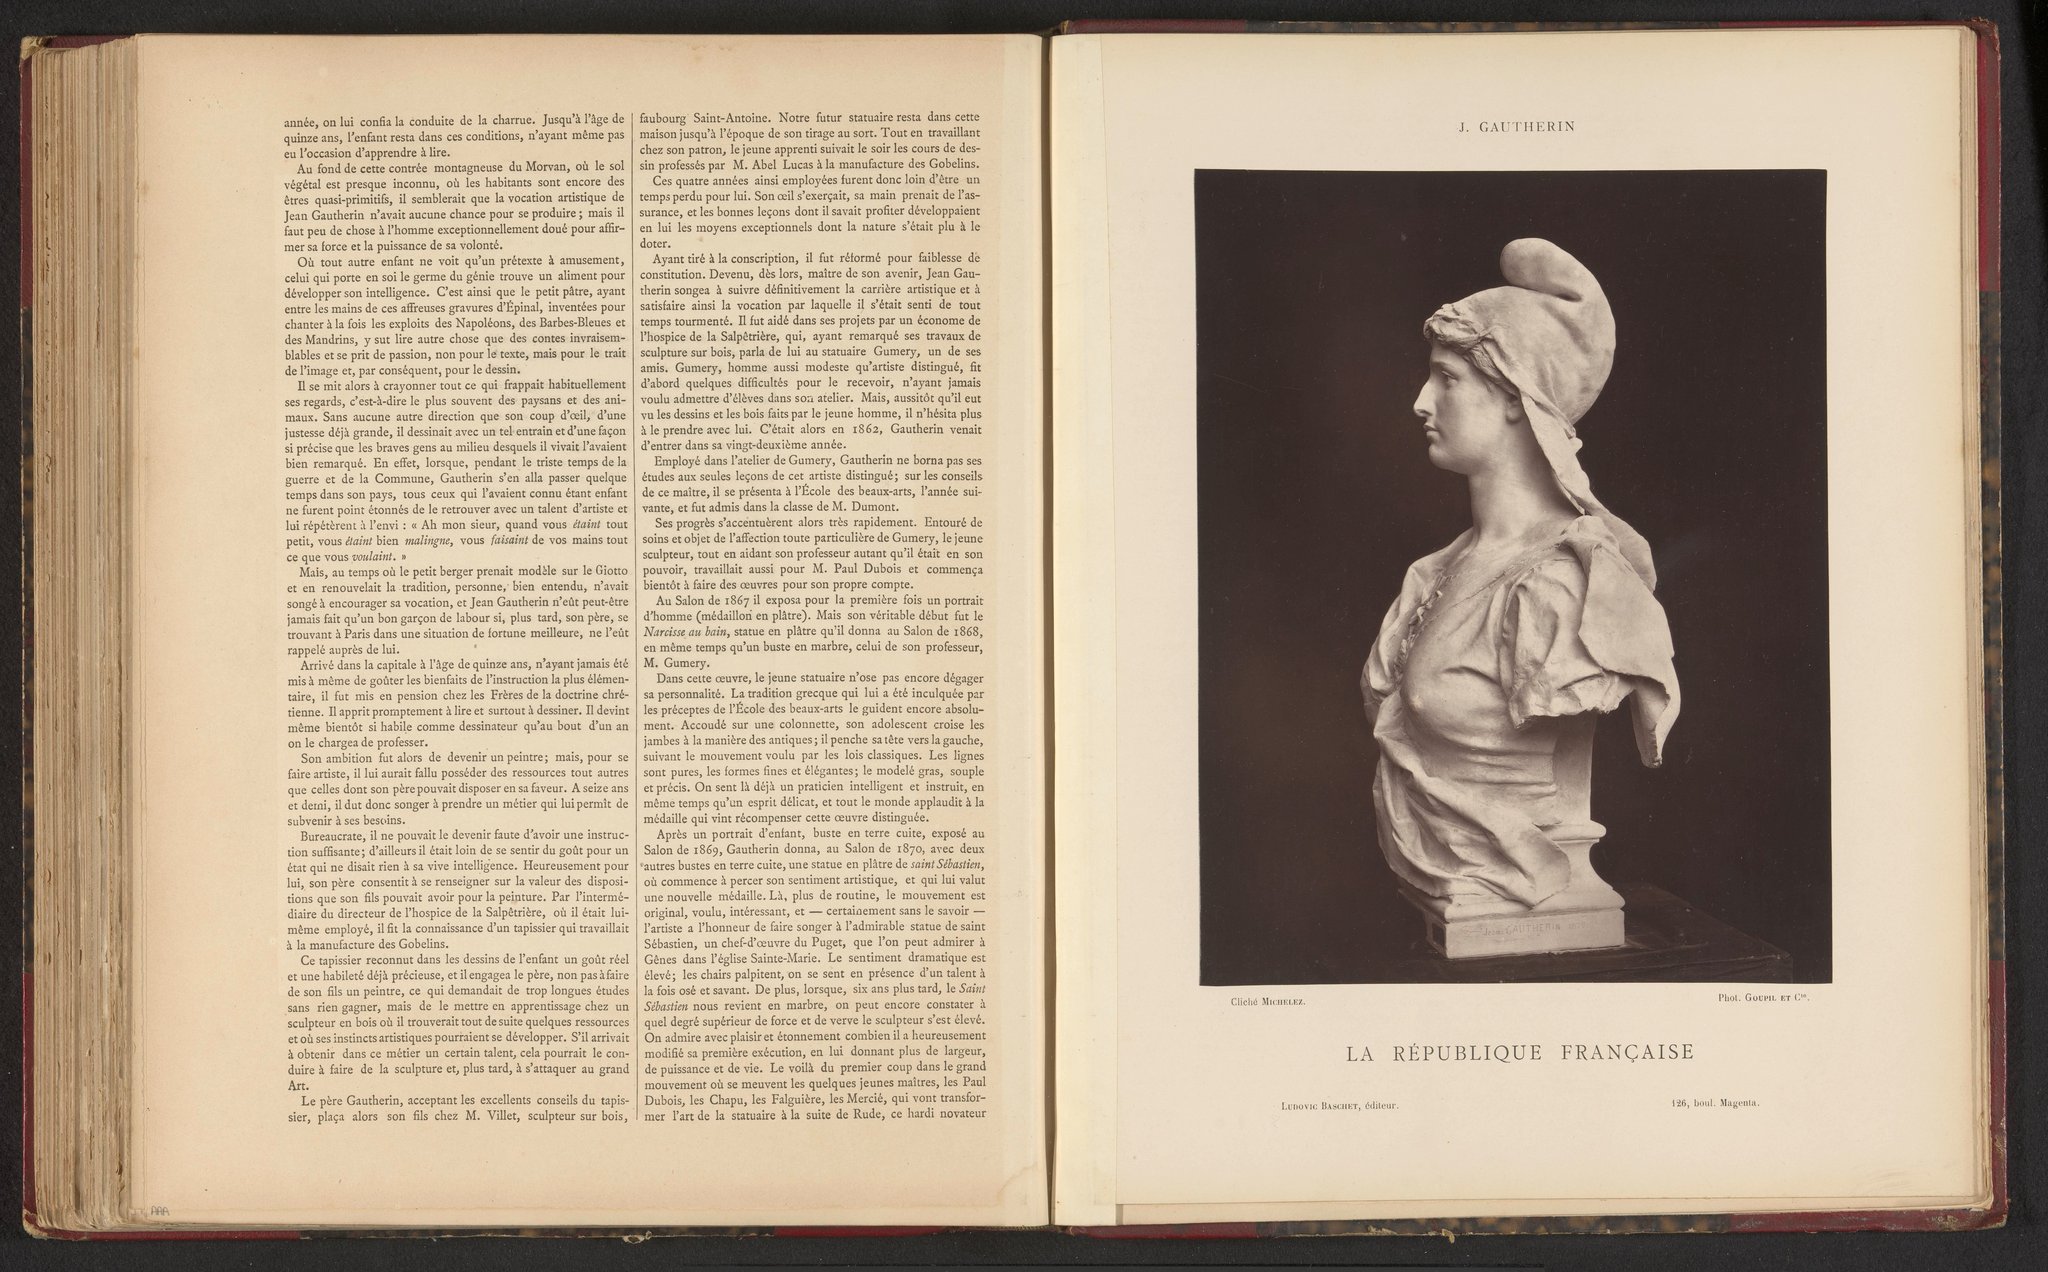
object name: page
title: La République Française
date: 1876-1879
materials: paper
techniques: woodburytype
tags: piece of sculpture, reproduction of a piece of sculpture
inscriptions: inscription: ‘126, boul. Magenta.’